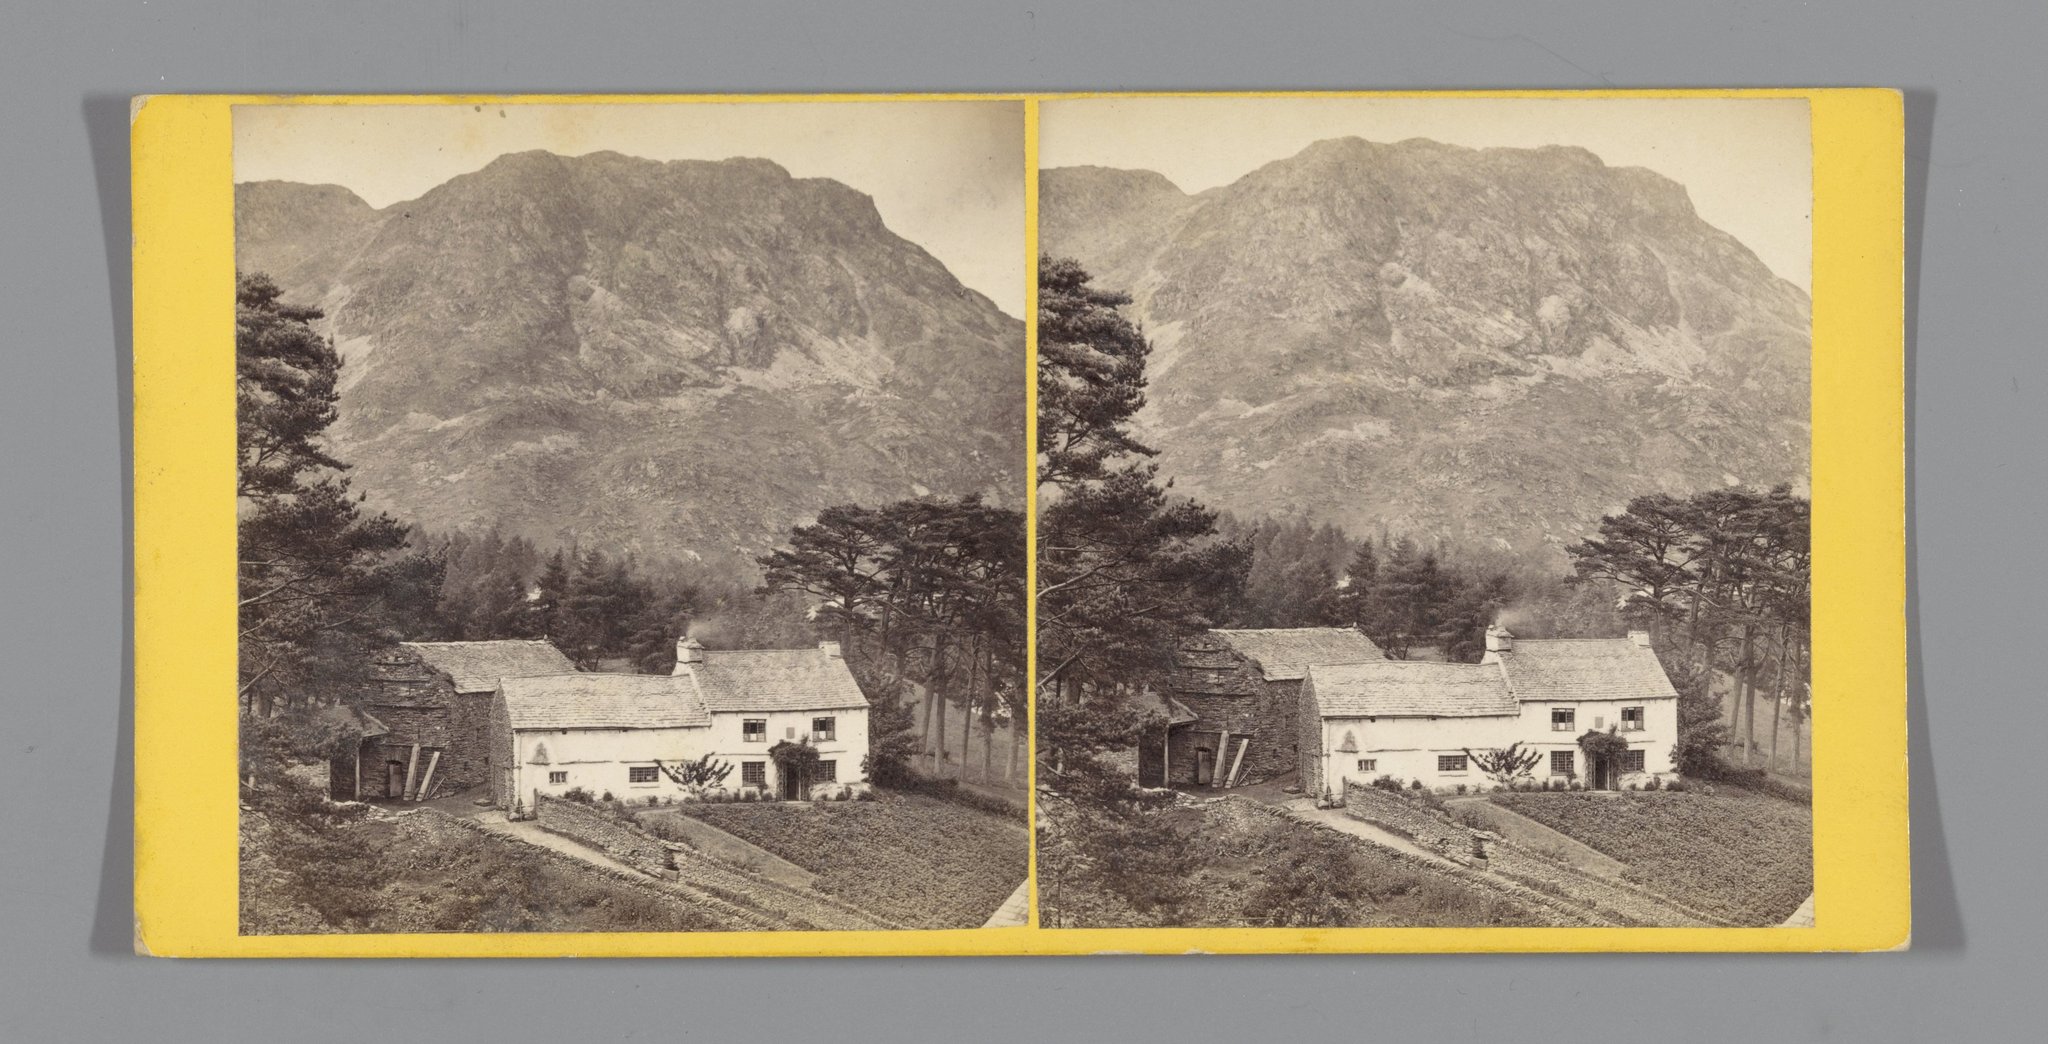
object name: stereograph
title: Gebouw te Coniston, met op de achtergrond een berg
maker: george washington wilson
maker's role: publisher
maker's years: 1823-1893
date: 1850-1880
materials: cardboard, photographic support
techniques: albumen print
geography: coniston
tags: façade (of house or building), mountains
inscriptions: name: ‘Registered. G. W. Wilson, Photographer, Aberdeen.’, number: ‘No. 560 A.’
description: Het object RP-F-F04846 is vermoedelijk tijdens dezelfde fotografeersessie gemaakt.